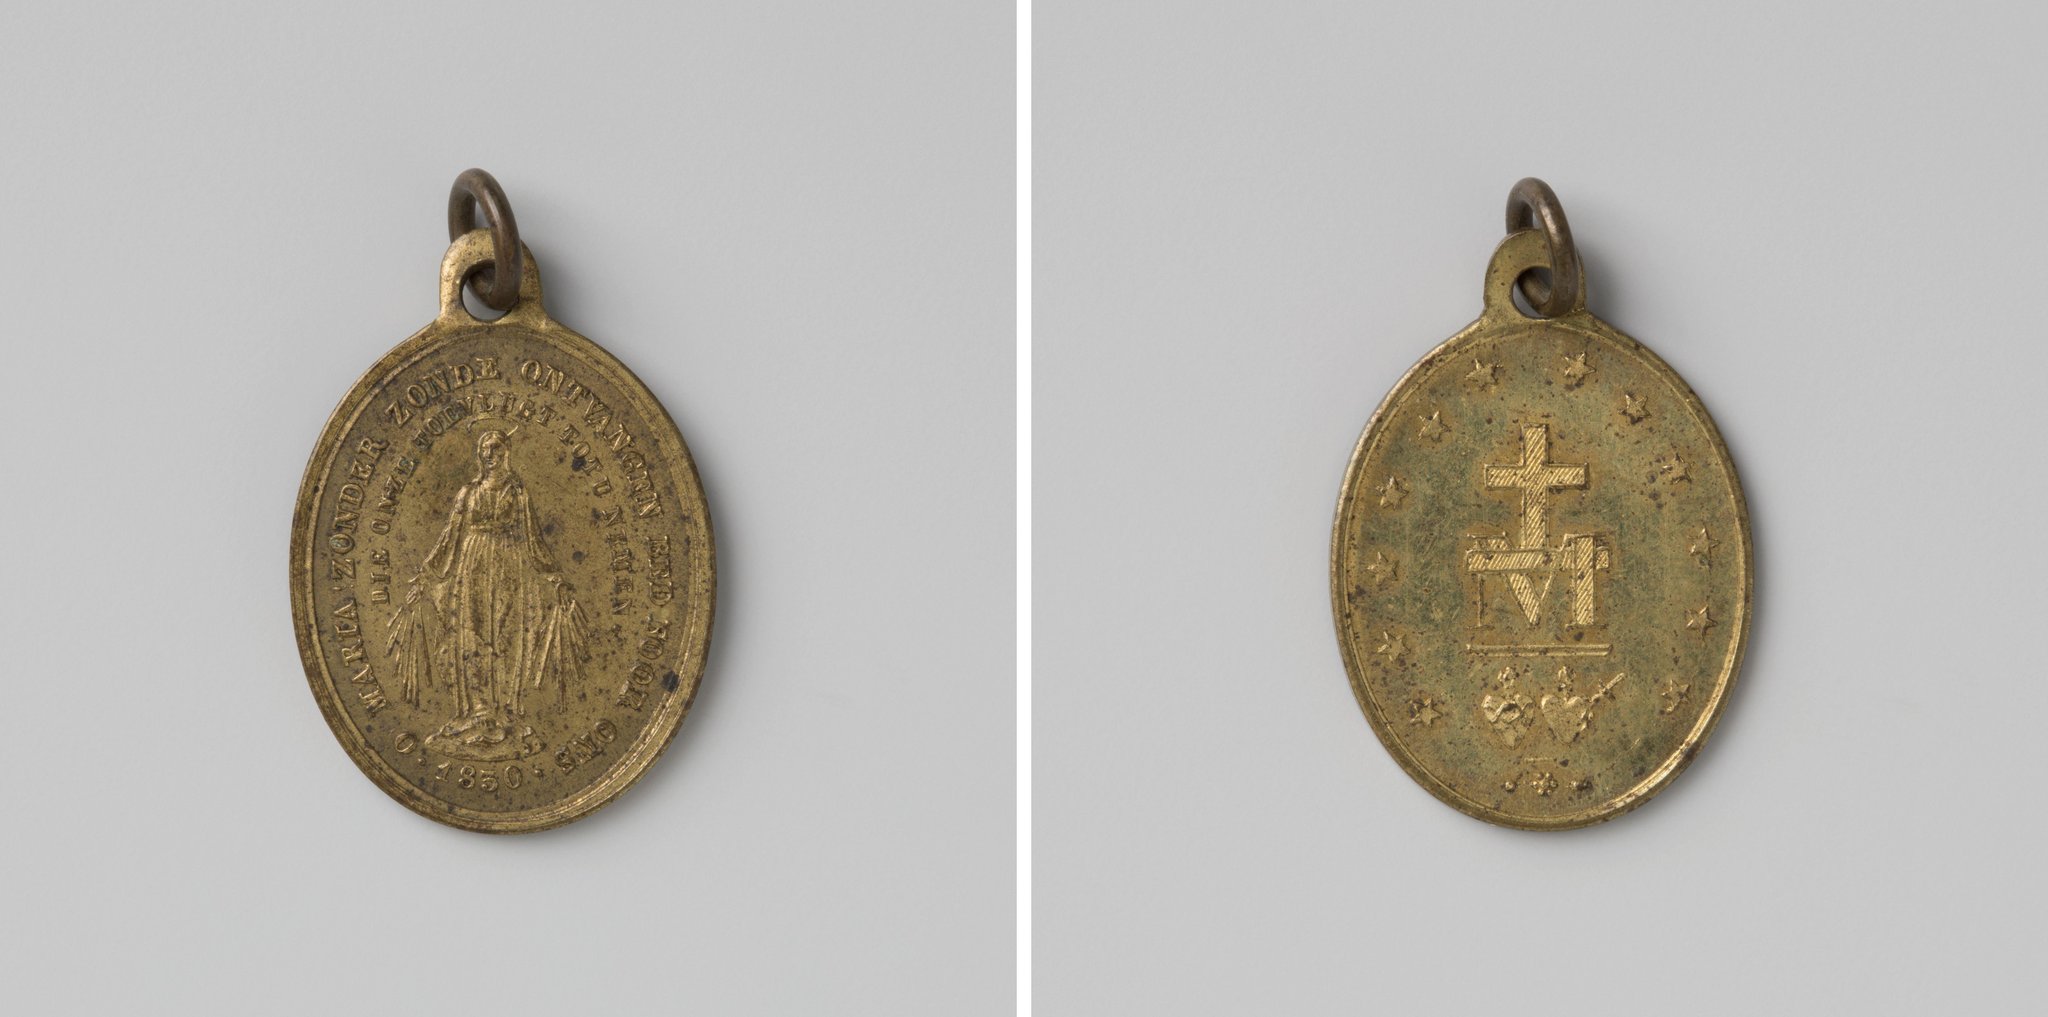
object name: devotional medal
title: Mirakuleuze medaille, devotiepenning gewijd aan de Onbevlekte Ontvangenis van de Maagd Maria en de devotie tot de Heilige Harten van Christus en Maria, vervaardigd naar aanleiding van de verschijning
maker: Anonymous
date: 1830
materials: brass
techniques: striking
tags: paris